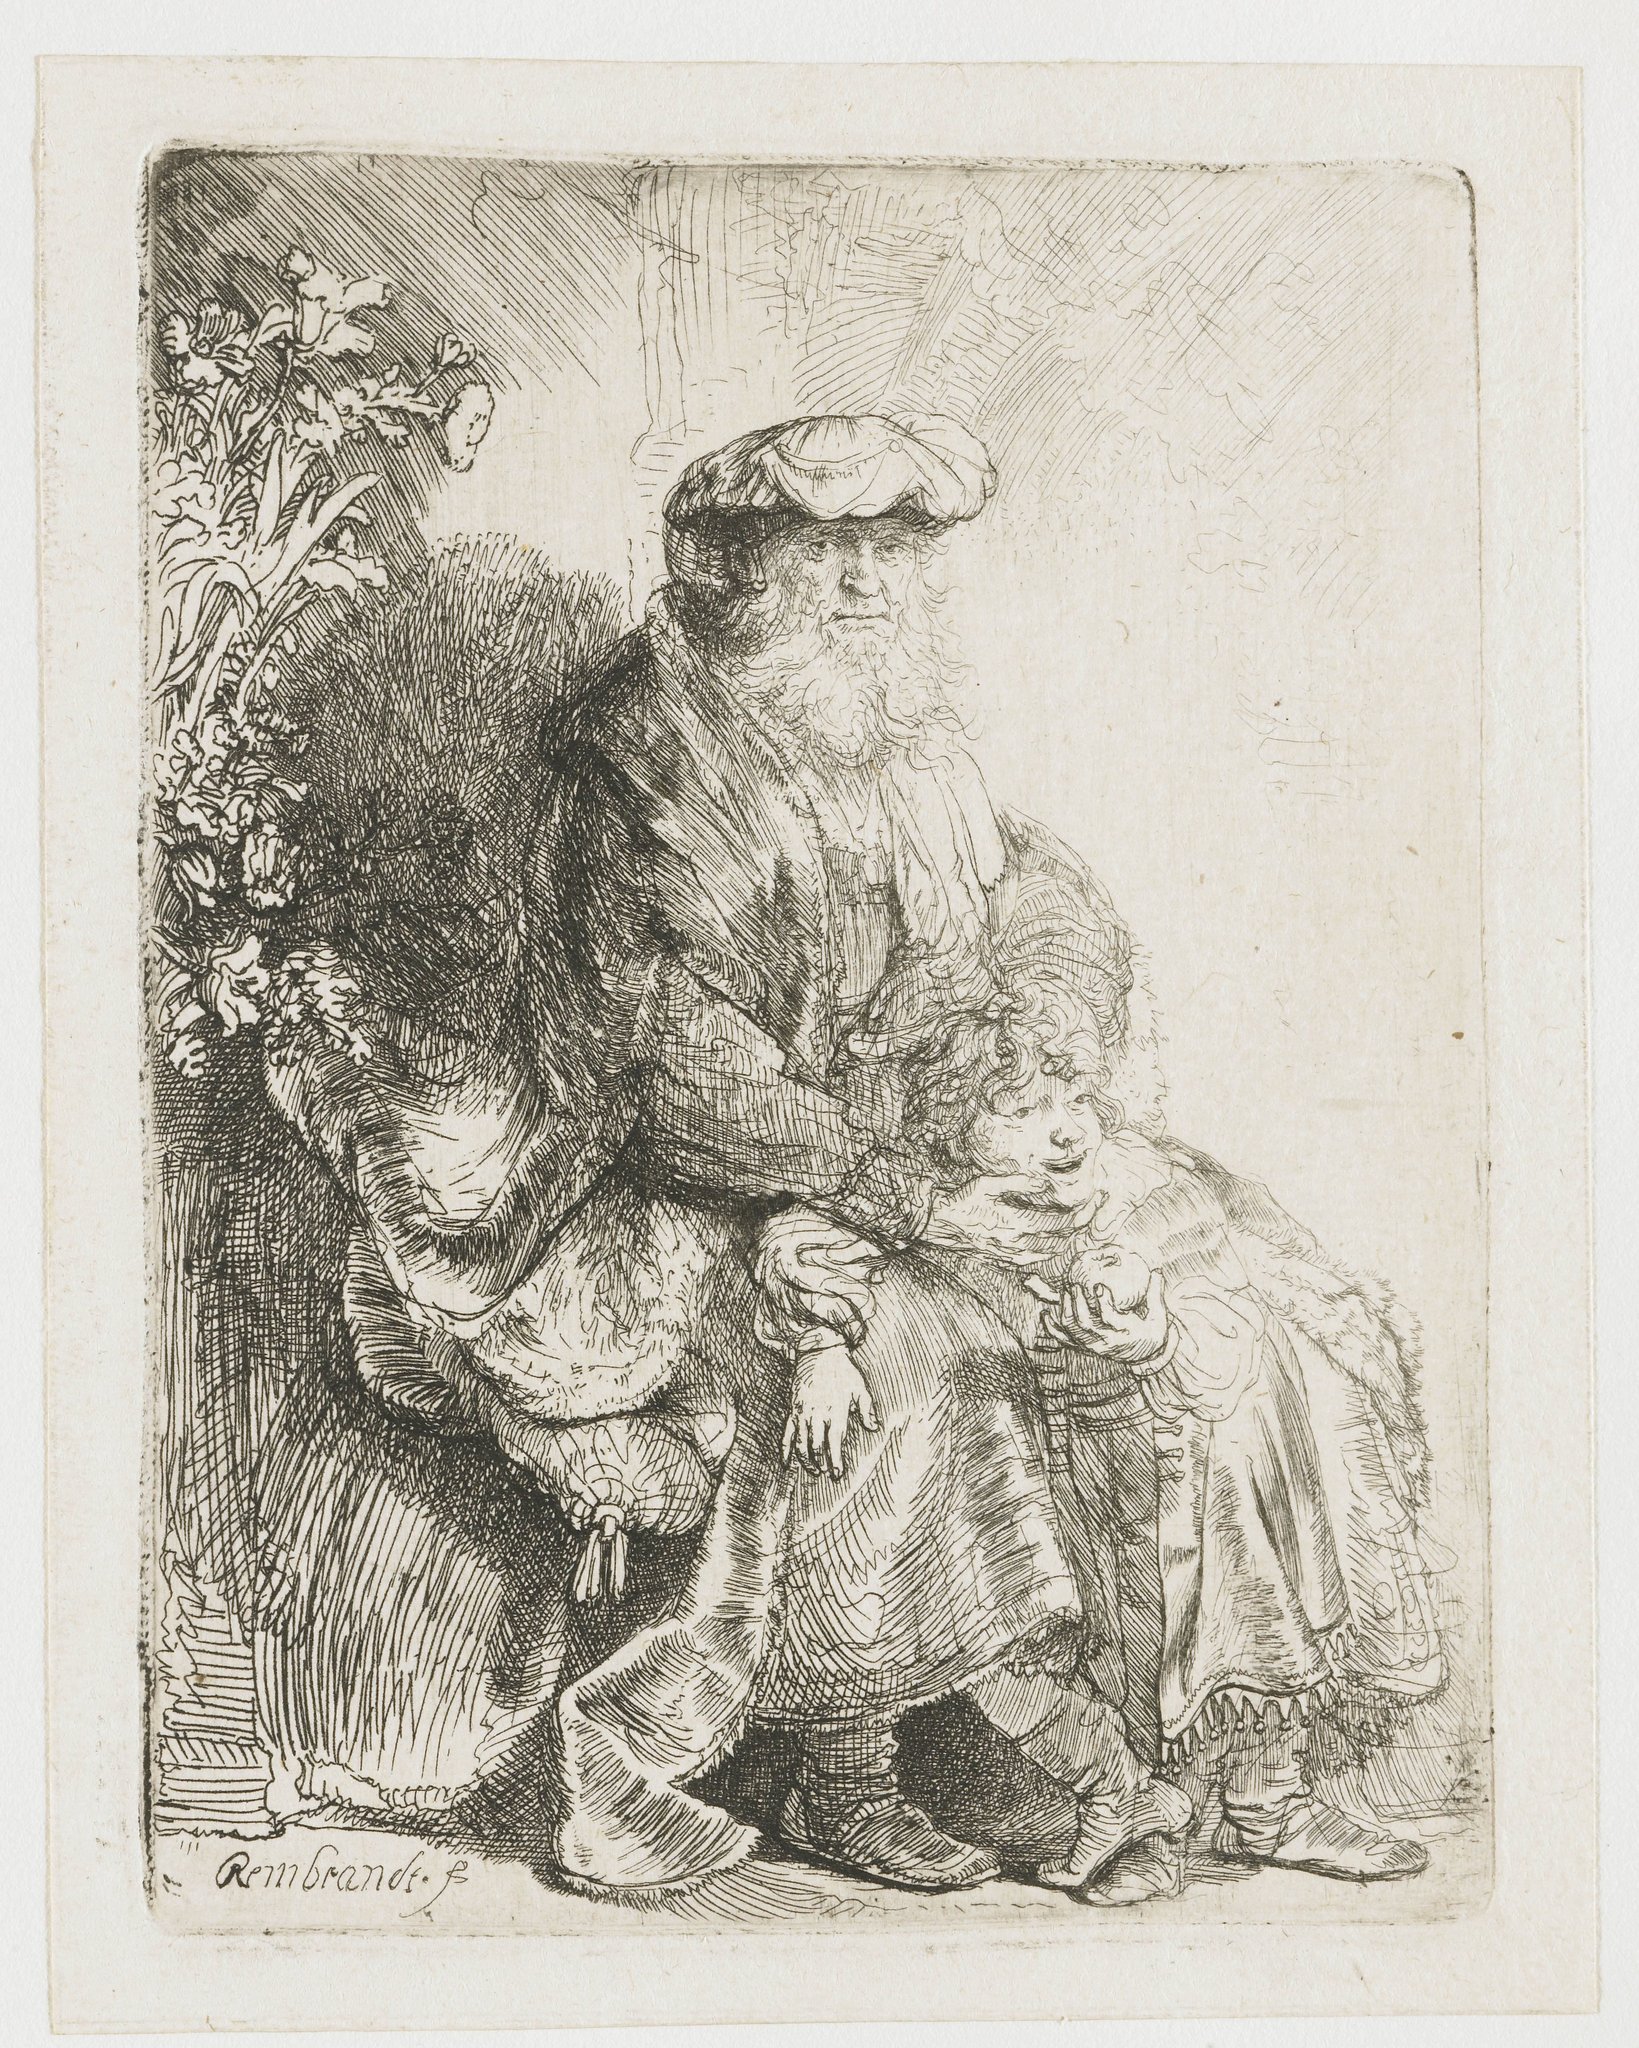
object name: print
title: Abraham caressing Isaac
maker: rembrandt van rijn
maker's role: draughtsman, painter, print maker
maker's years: 1606-1669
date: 1637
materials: paper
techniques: etching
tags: story of abraham, story of jacob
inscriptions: signature: ‘Rembrandt f.’, inscription: ‘1643 7/12’, collector's mark: Lugt 240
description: This is above all a charming depiction of a father caressing his child. The aged Abraham ruffles the hair and cups the chin of his spirited little boy Isaac, who hangs over his knee. Abraham looks straight out at us, while Isaac’s attention is drawn to something beyond the picture plane, lending extra interest to the scene.